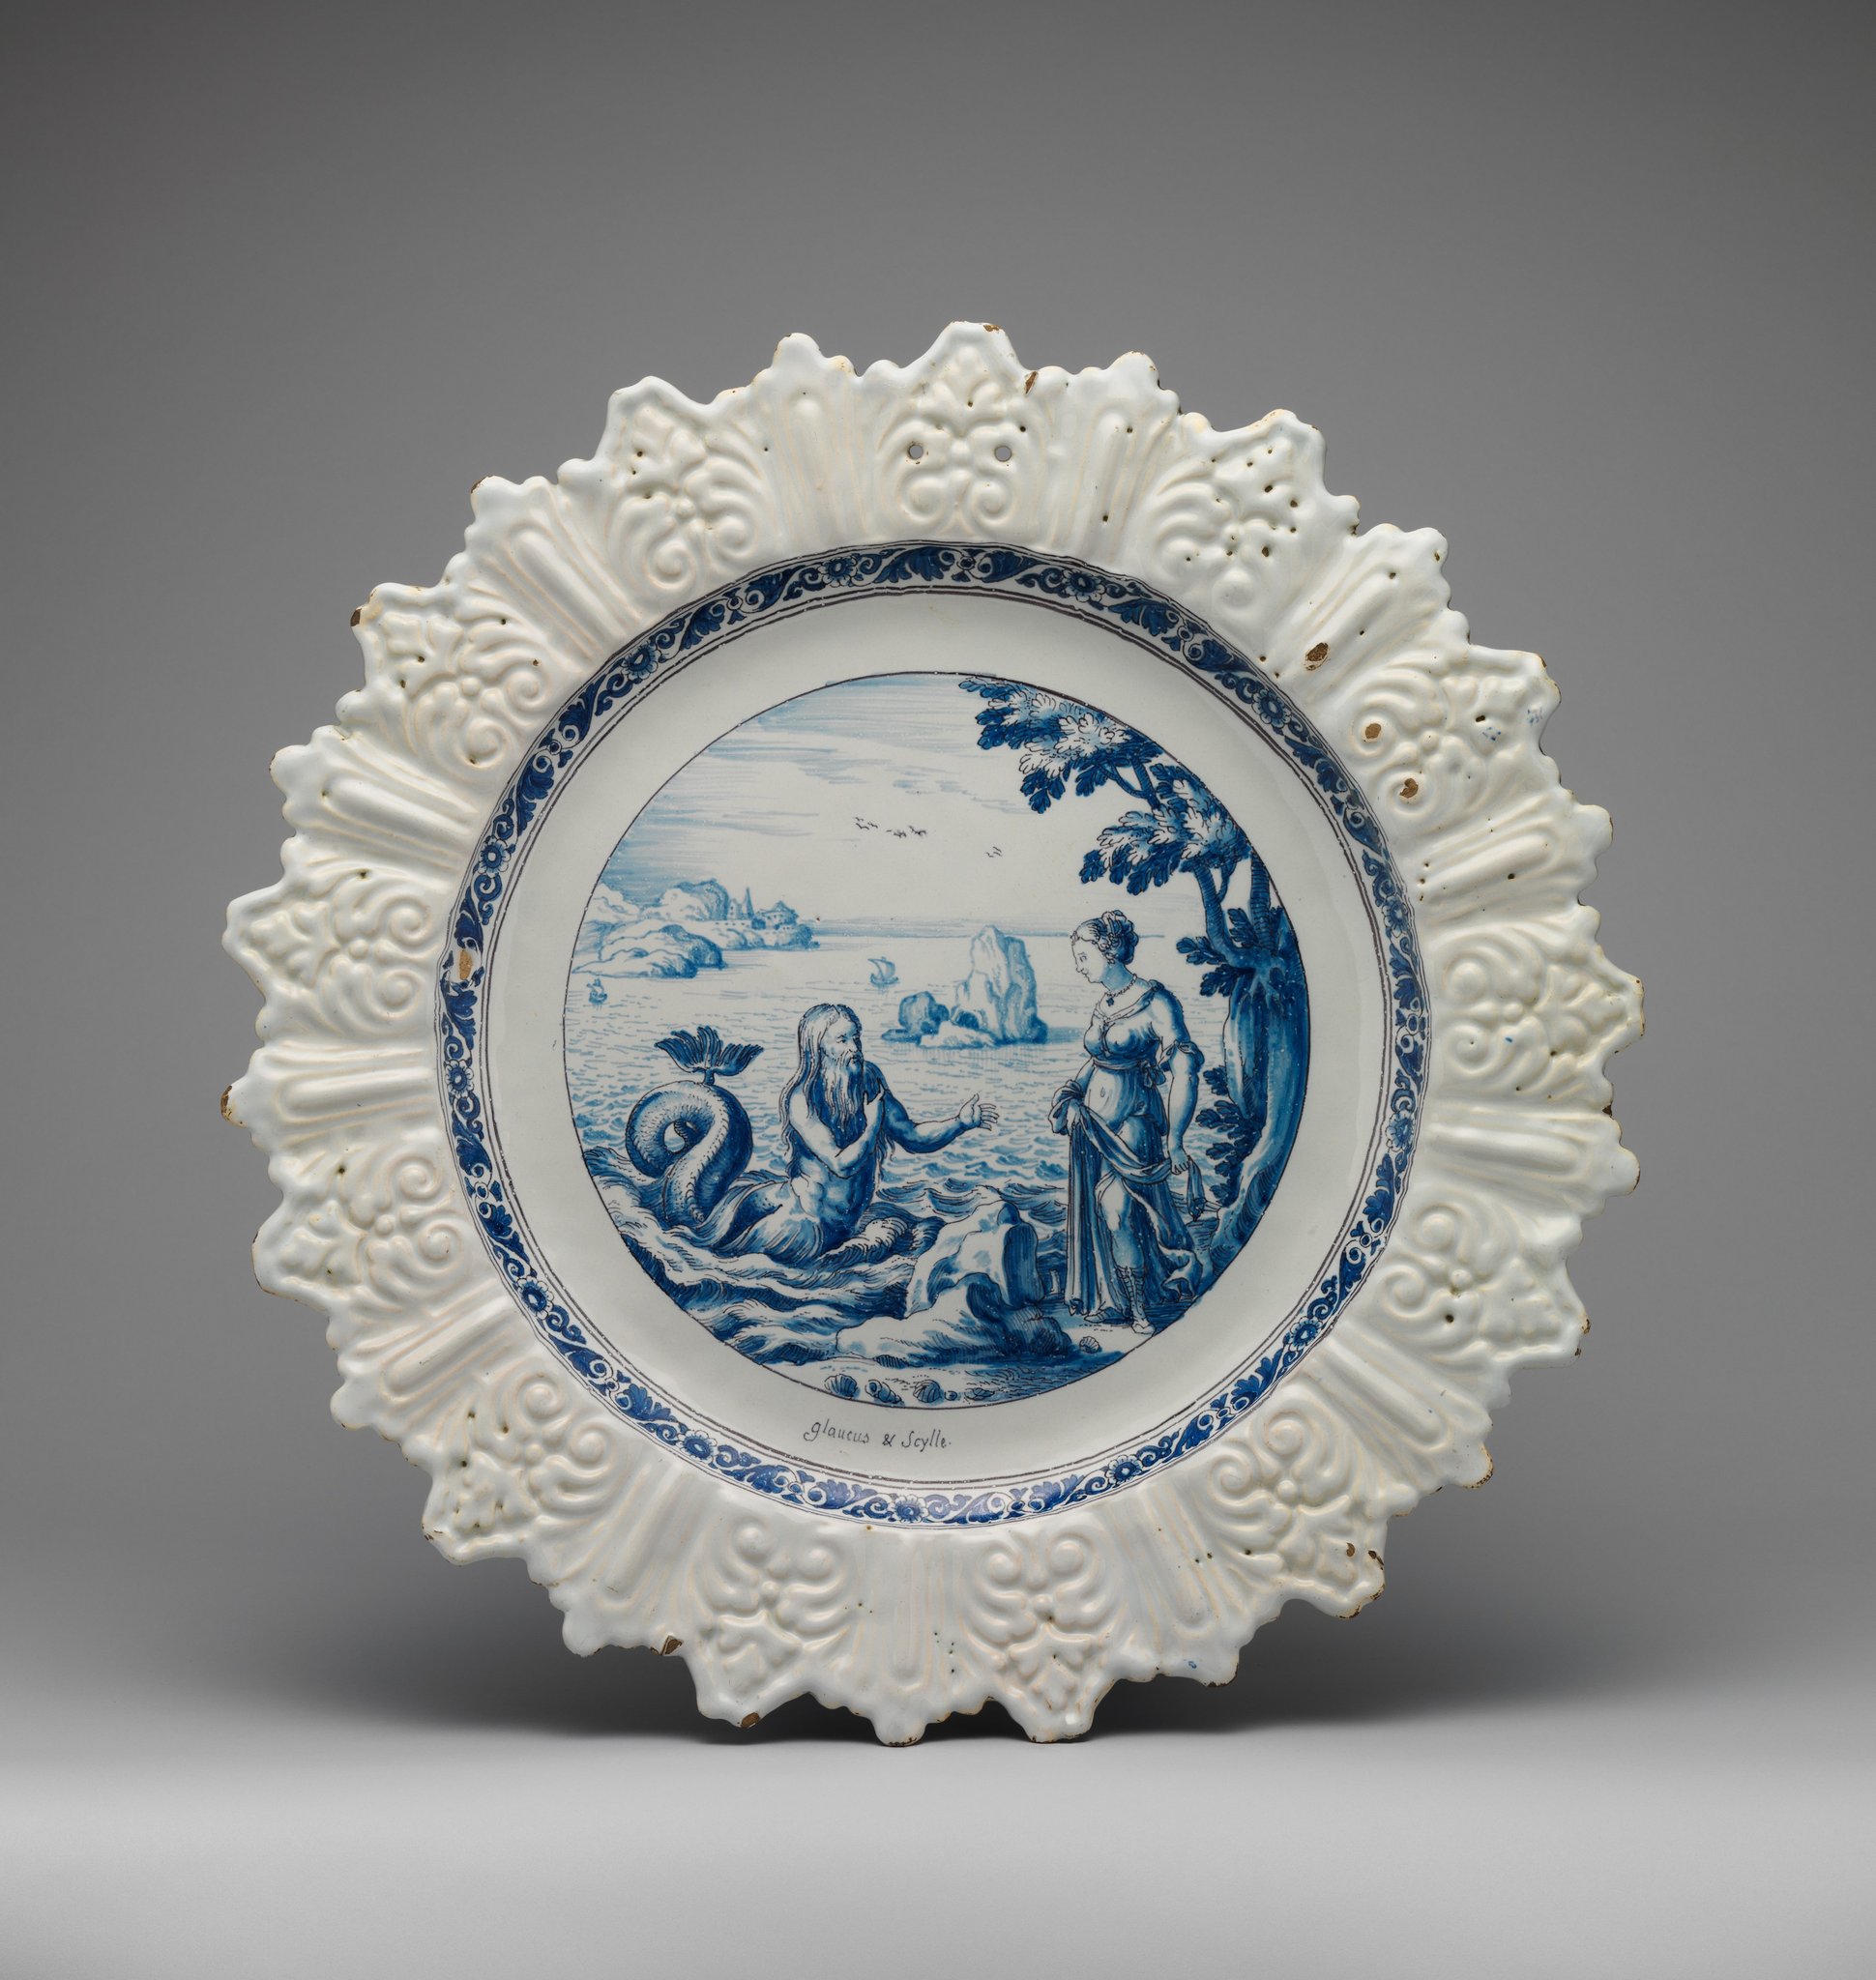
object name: dish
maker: saint-jean-du-désert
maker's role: factory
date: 1667-1700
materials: faience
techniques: glazing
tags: women,mermen